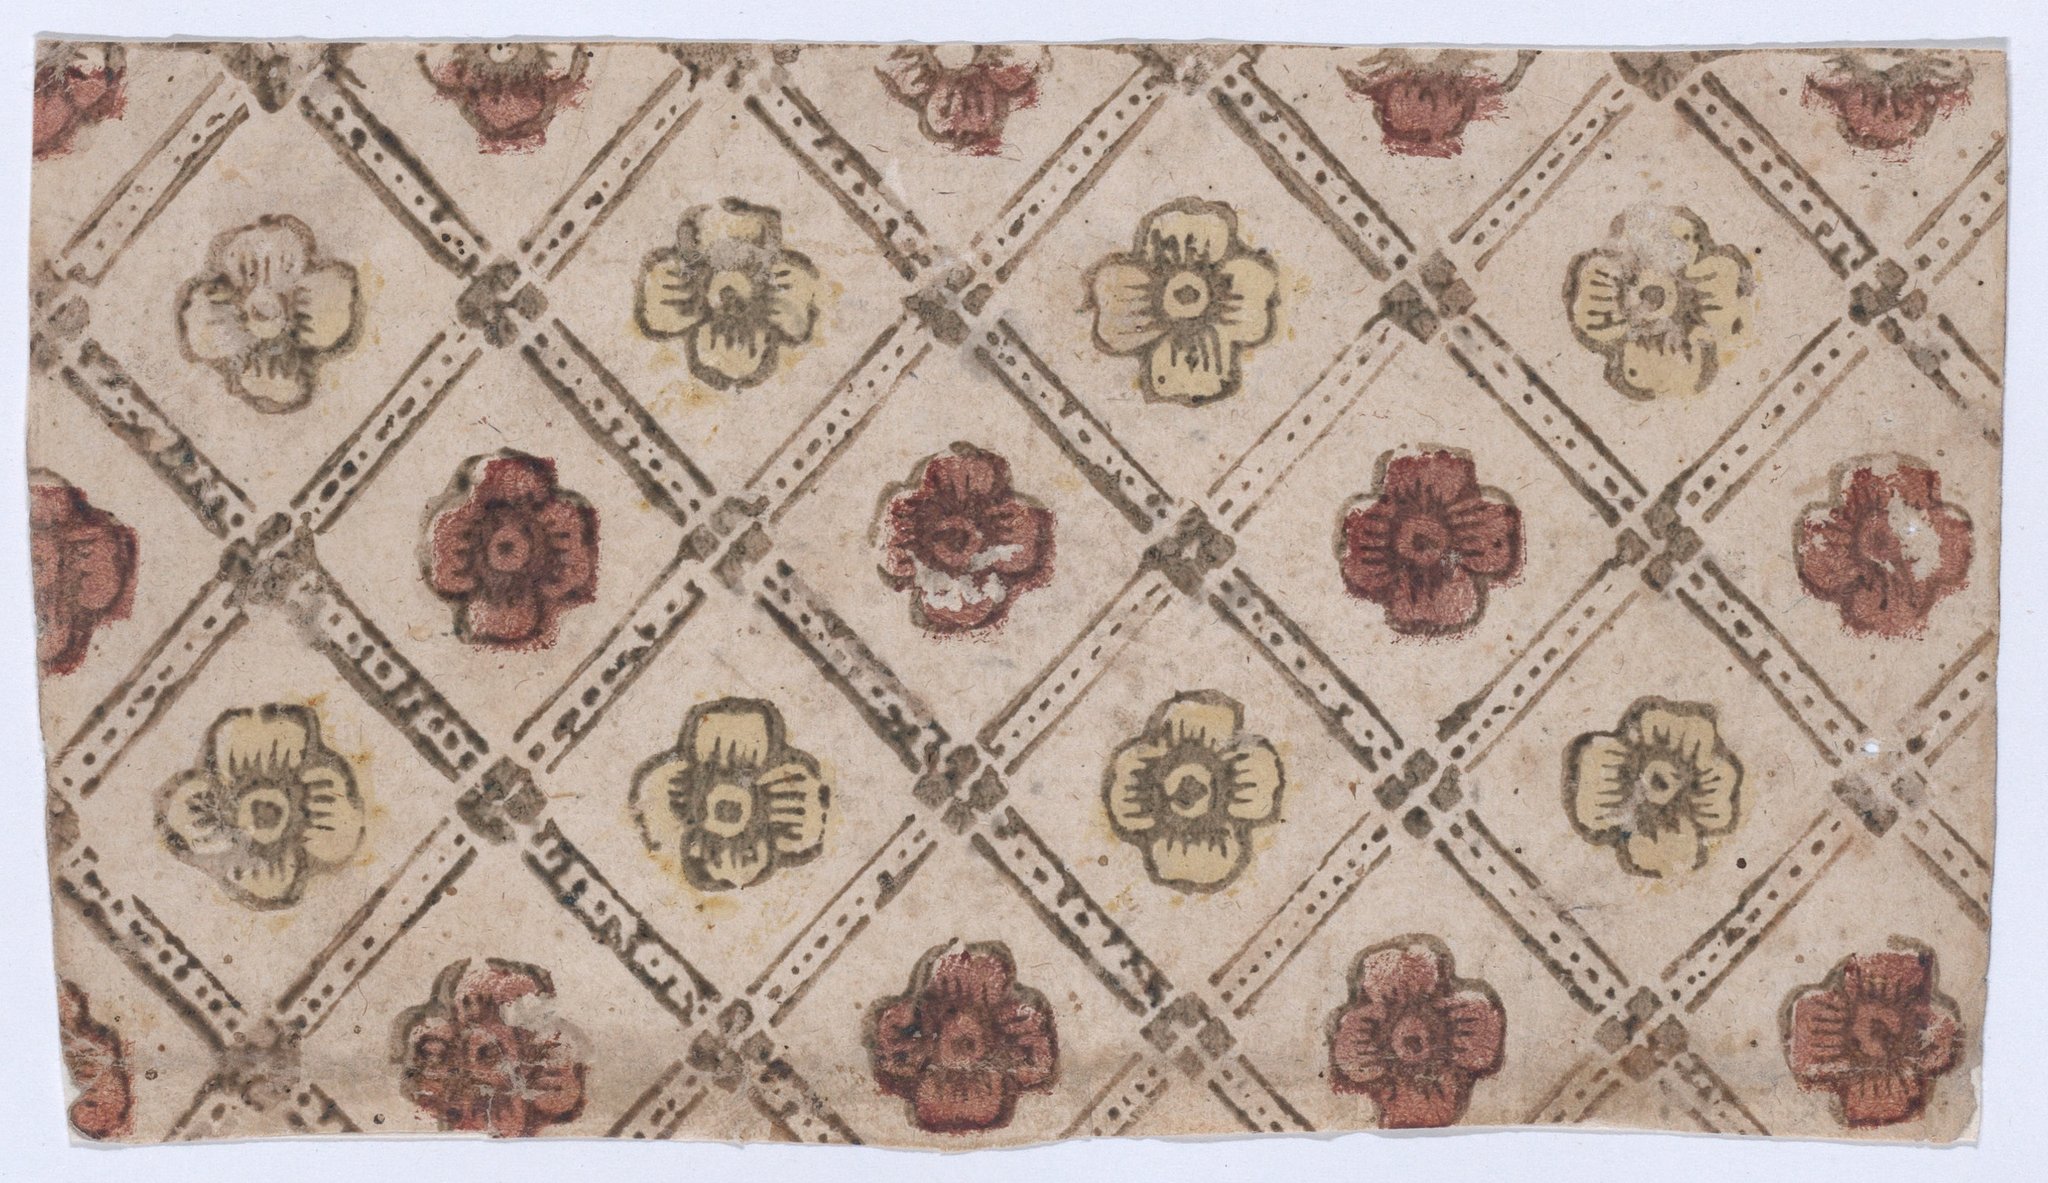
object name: print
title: Sheet with overall pattern of rosettes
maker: Anonymous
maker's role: artist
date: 1801-1900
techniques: relief print